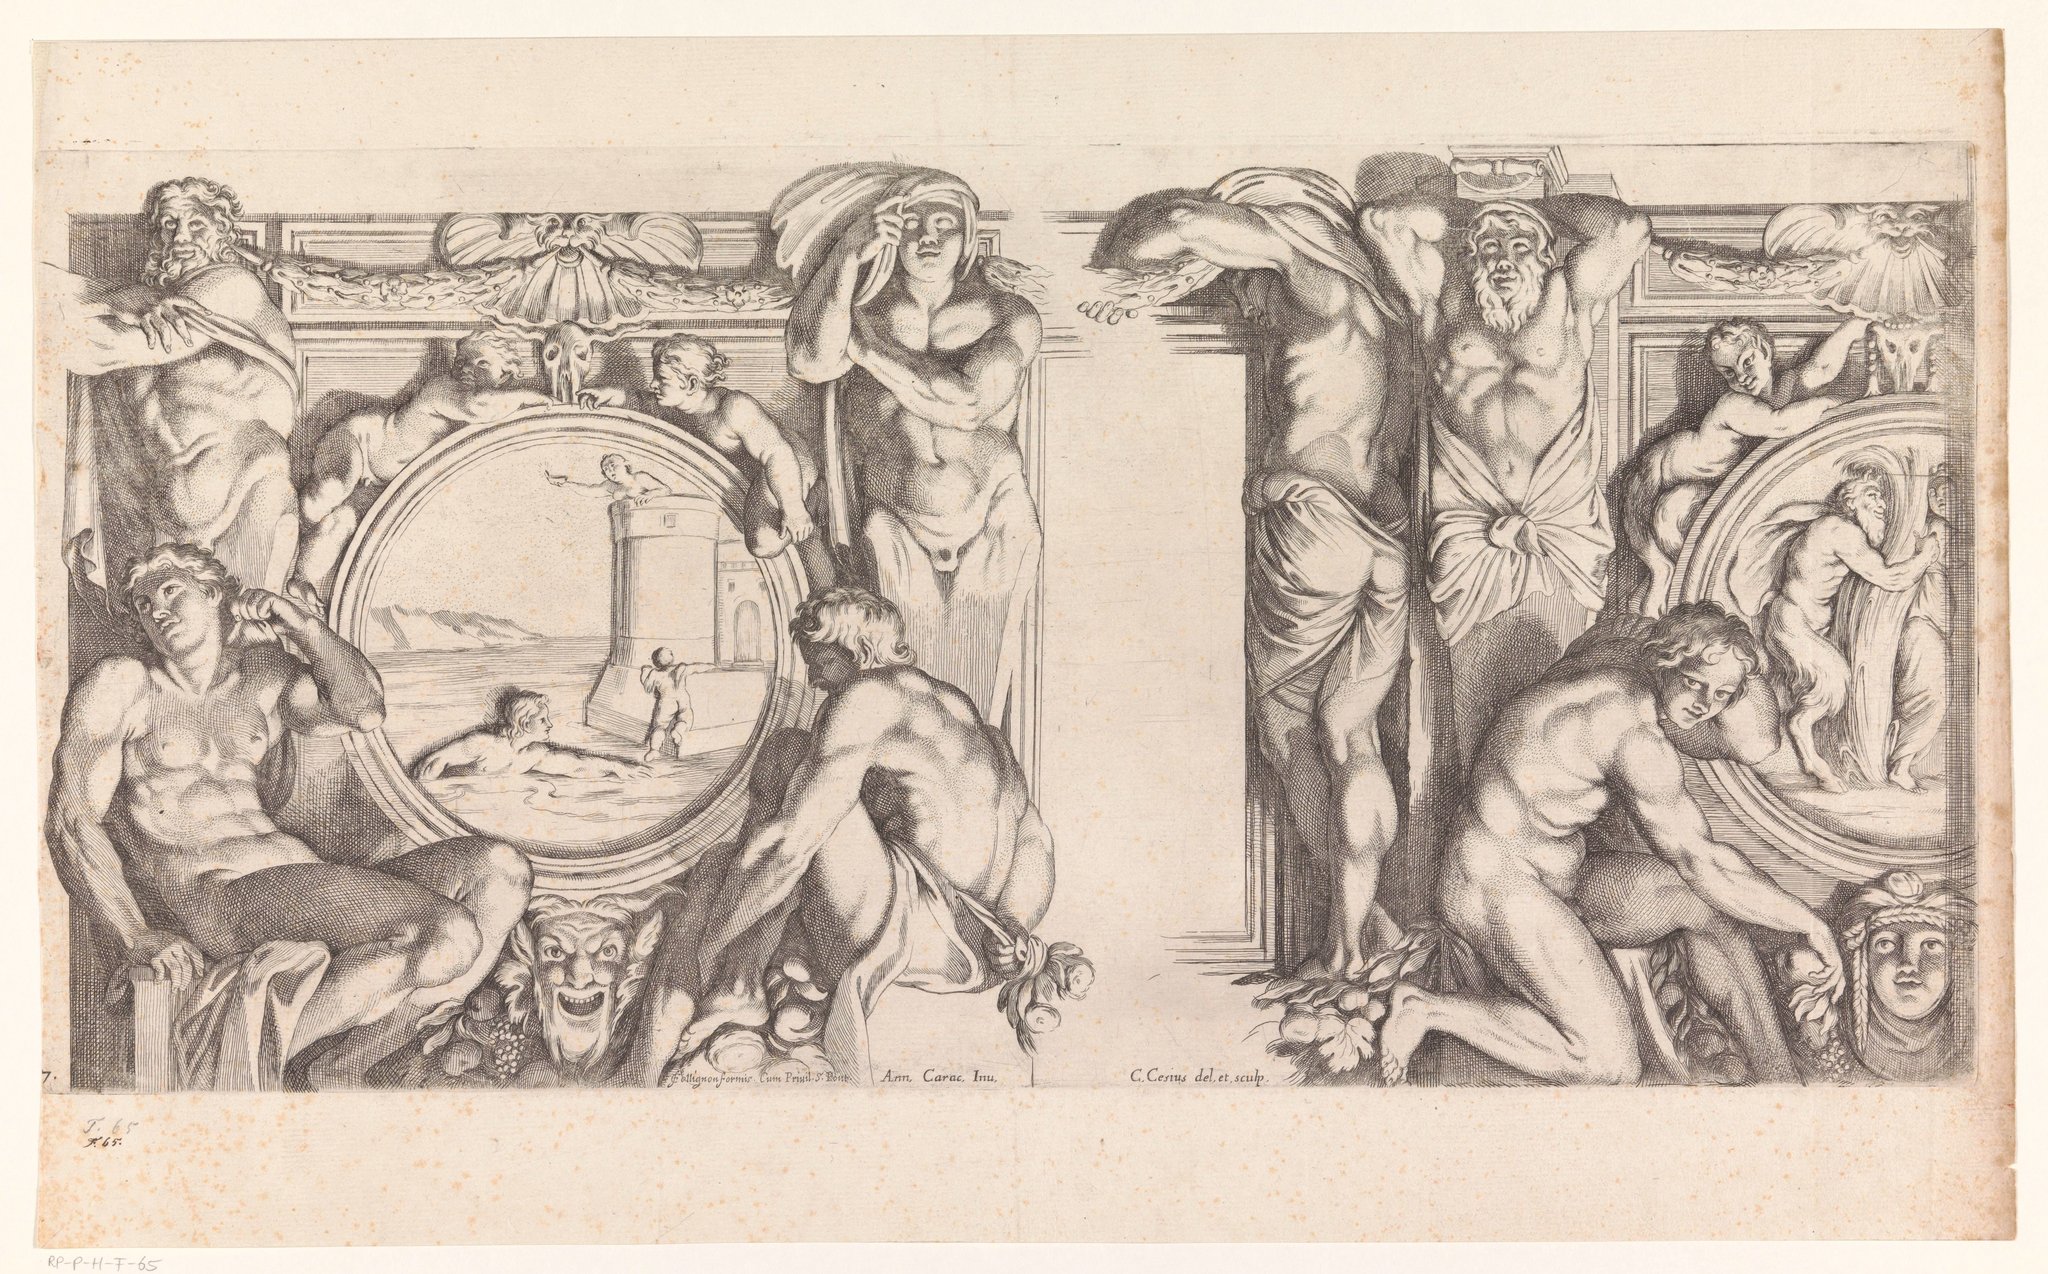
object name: print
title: Schilderingen in Palazzo Farnese te Rome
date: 1656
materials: paper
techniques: etching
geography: italy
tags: triumph of bacchus and ariadne, (story of) bacchus (dionysus), liber, (story of) ariadne, satyr(s) (in general), cupids: 'amores', 'amoretti', 'putti'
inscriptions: collector's mark: ‘Hinloopen’, collector's mark: Lugt 11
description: Een triomfoptocht van Bacchus en Ariadne. De triomfwagen van Bacchus wordt voortgetrokken door leeuwen. De wagen van Ariadne wordt voortgetrokken door geiten. Voorop loopt een groep saters, bacchanten en de dronken Silenus op een ezel. In de lucht zweven putti.